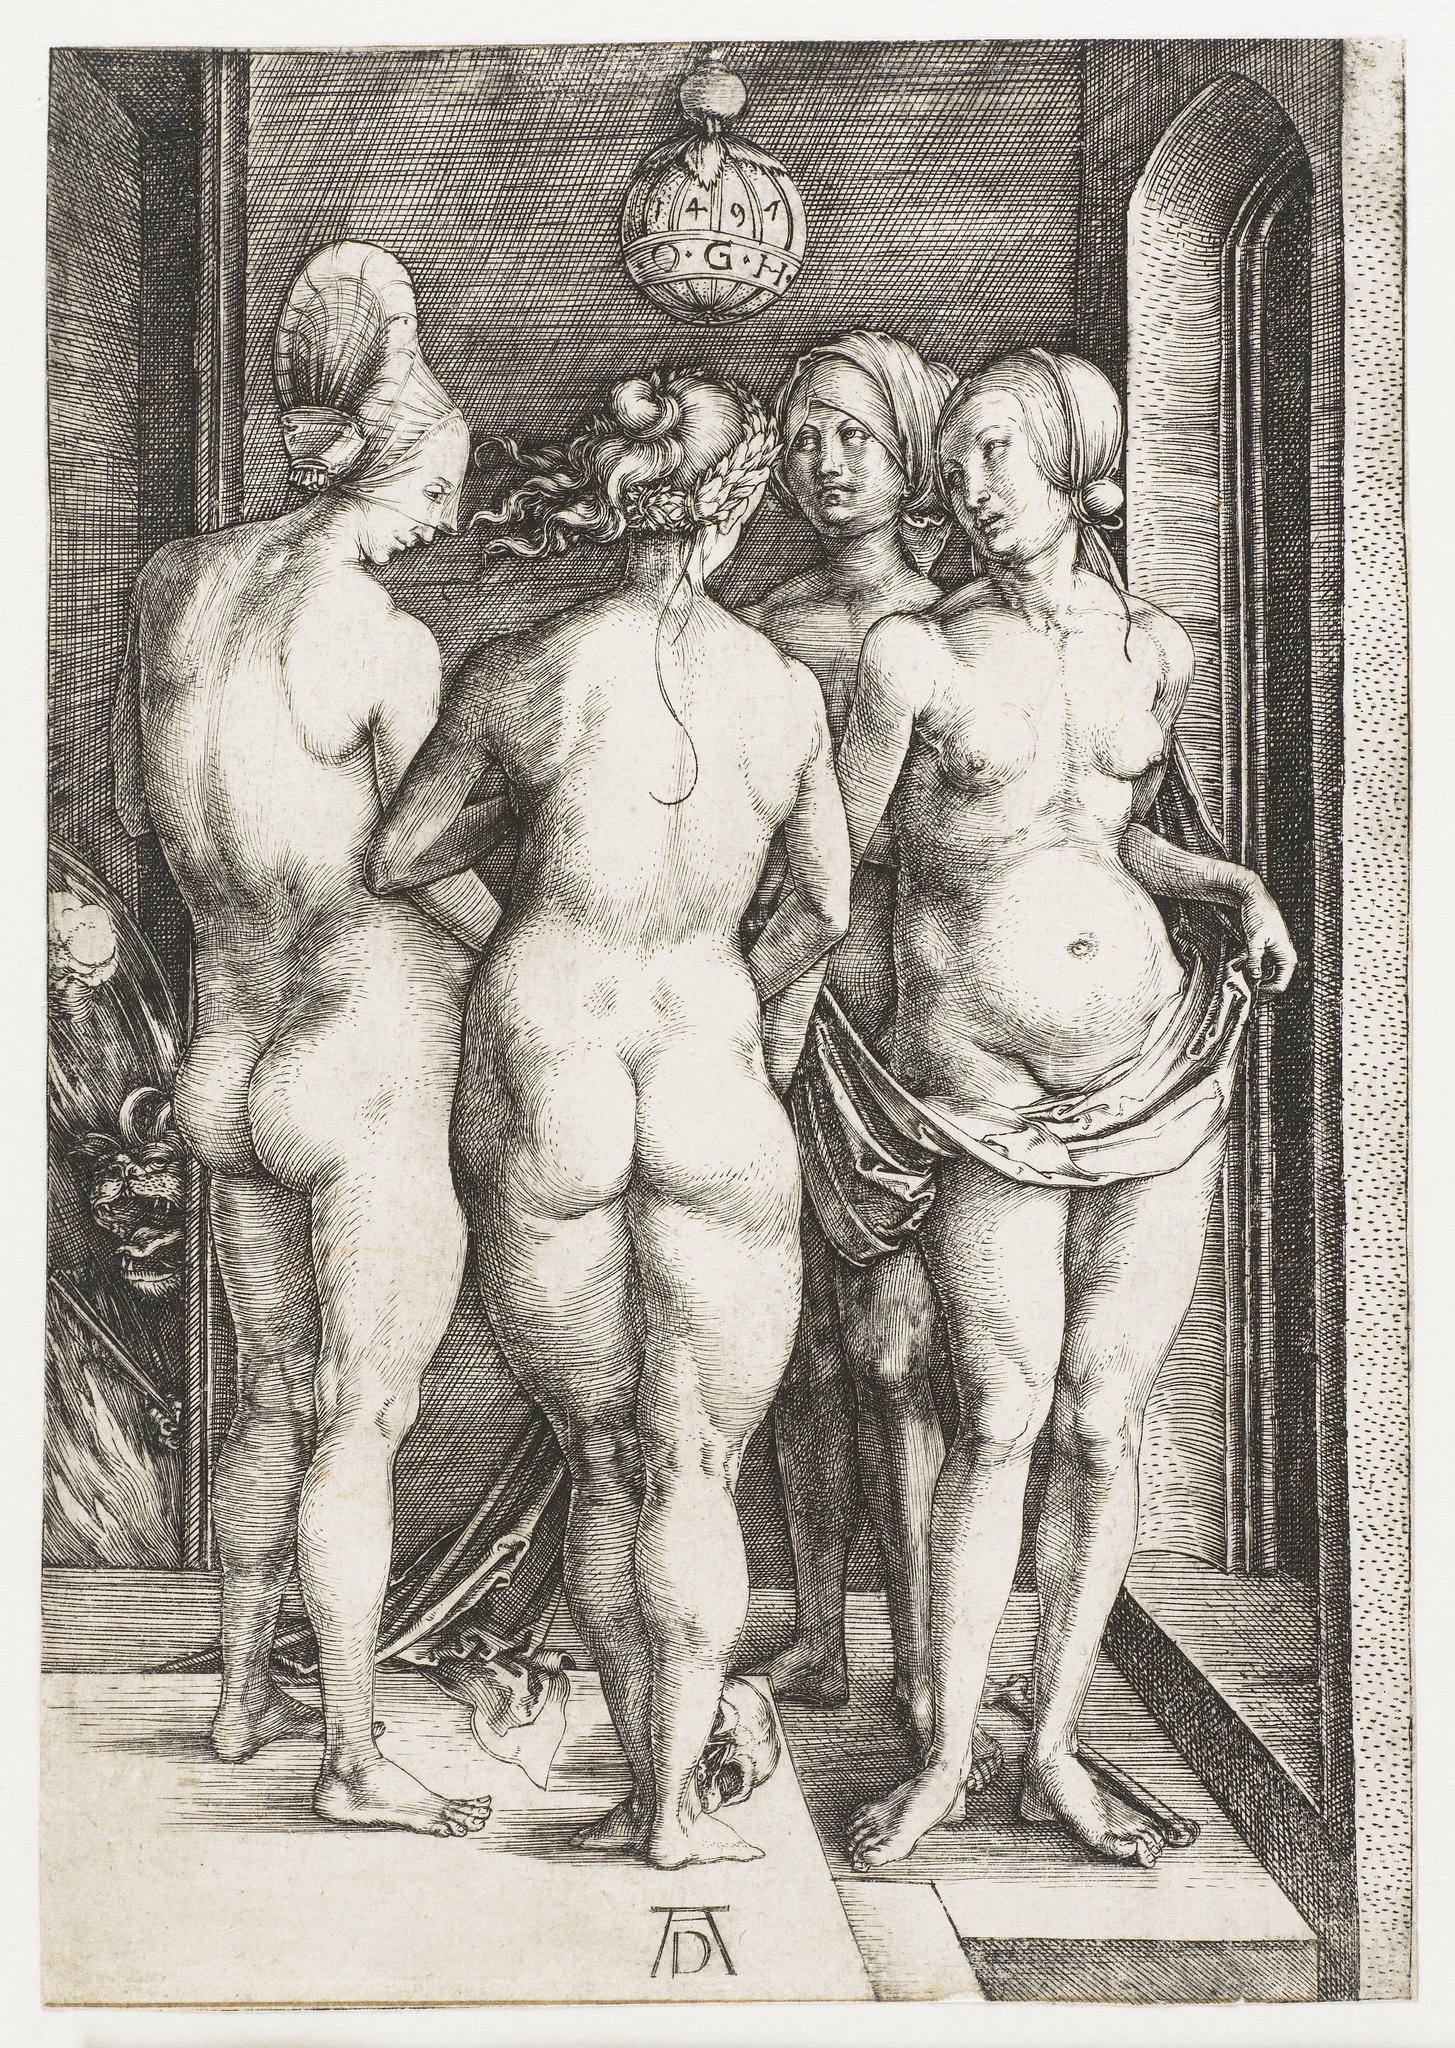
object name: print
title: Vier heksen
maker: albrecht dürer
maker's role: draughtsman, painter, print maker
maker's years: 1471-1528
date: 1497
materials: paper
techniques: engraving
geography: nuremberg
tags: the (nude) human figure; 'corpo humano' (ripa), groups of witches, entrance of hell as gate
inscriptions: collector's mark: Lugt 240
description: Vier naakte vrouwen staan in een vertrek nabij een lage poort waardoor vuur en een duivels monster te zien zijn. Boven de hoofden van de vrouwen hangt een bol waarop de letters OGH staan.